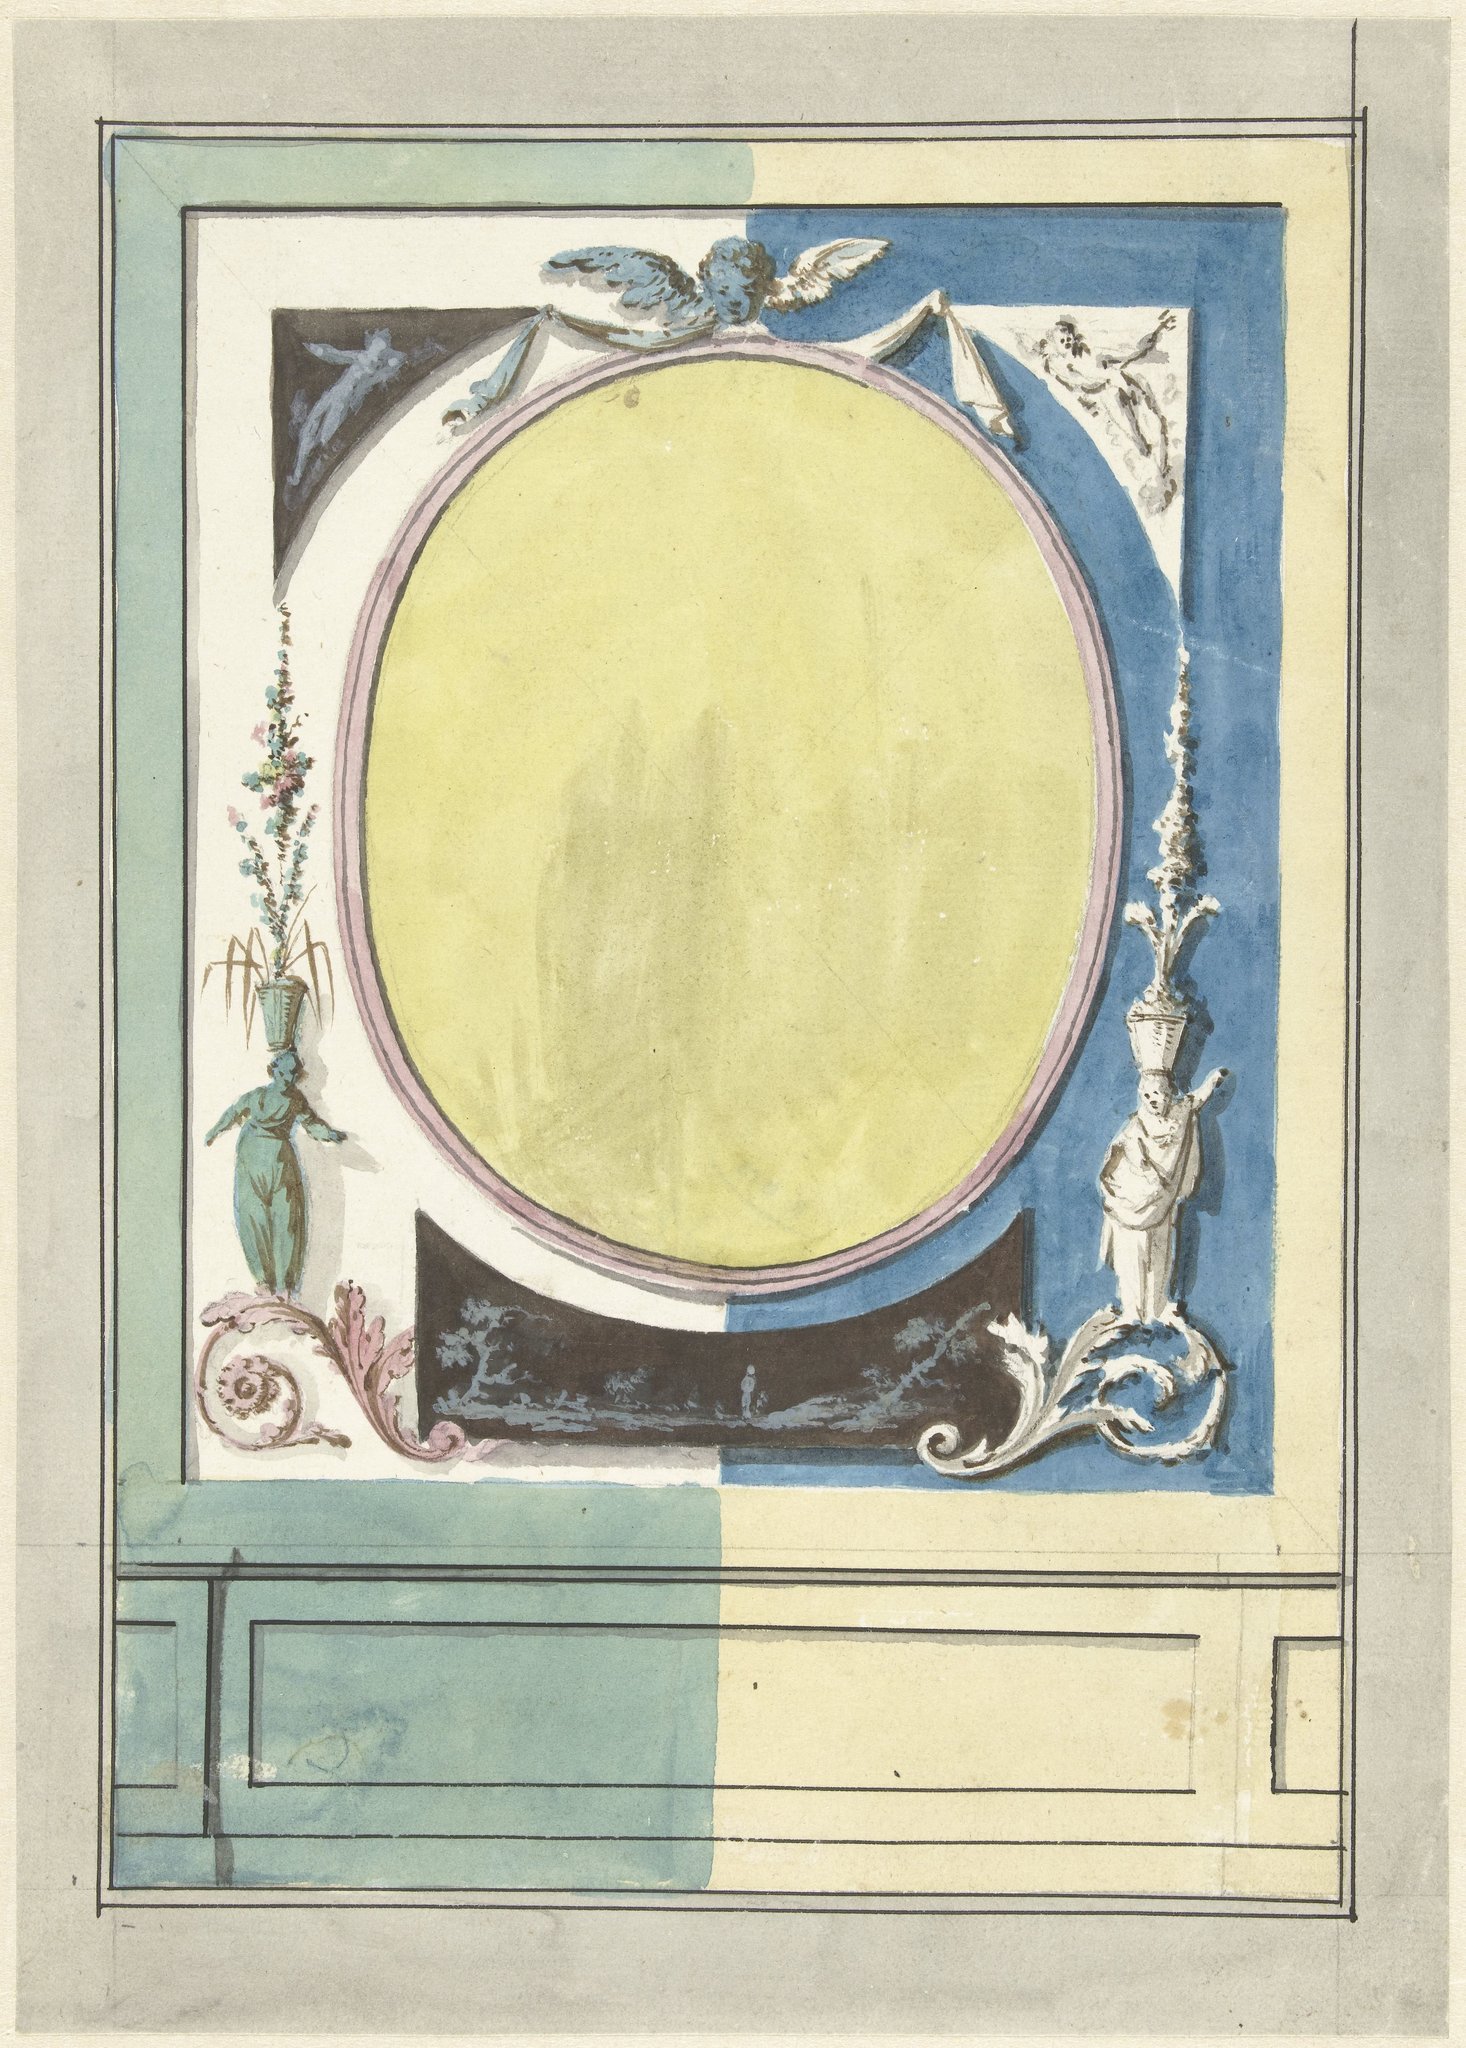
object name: drawing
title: Ontwerp voor kamerversiering met een paneel met centraal een gele ovaal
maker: abraham meertens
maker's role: draughtsman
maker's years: 1757-1823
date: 1767-1823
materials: paint, ink, paper, pencil, watercolor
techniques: brush, pen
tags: wall-covering